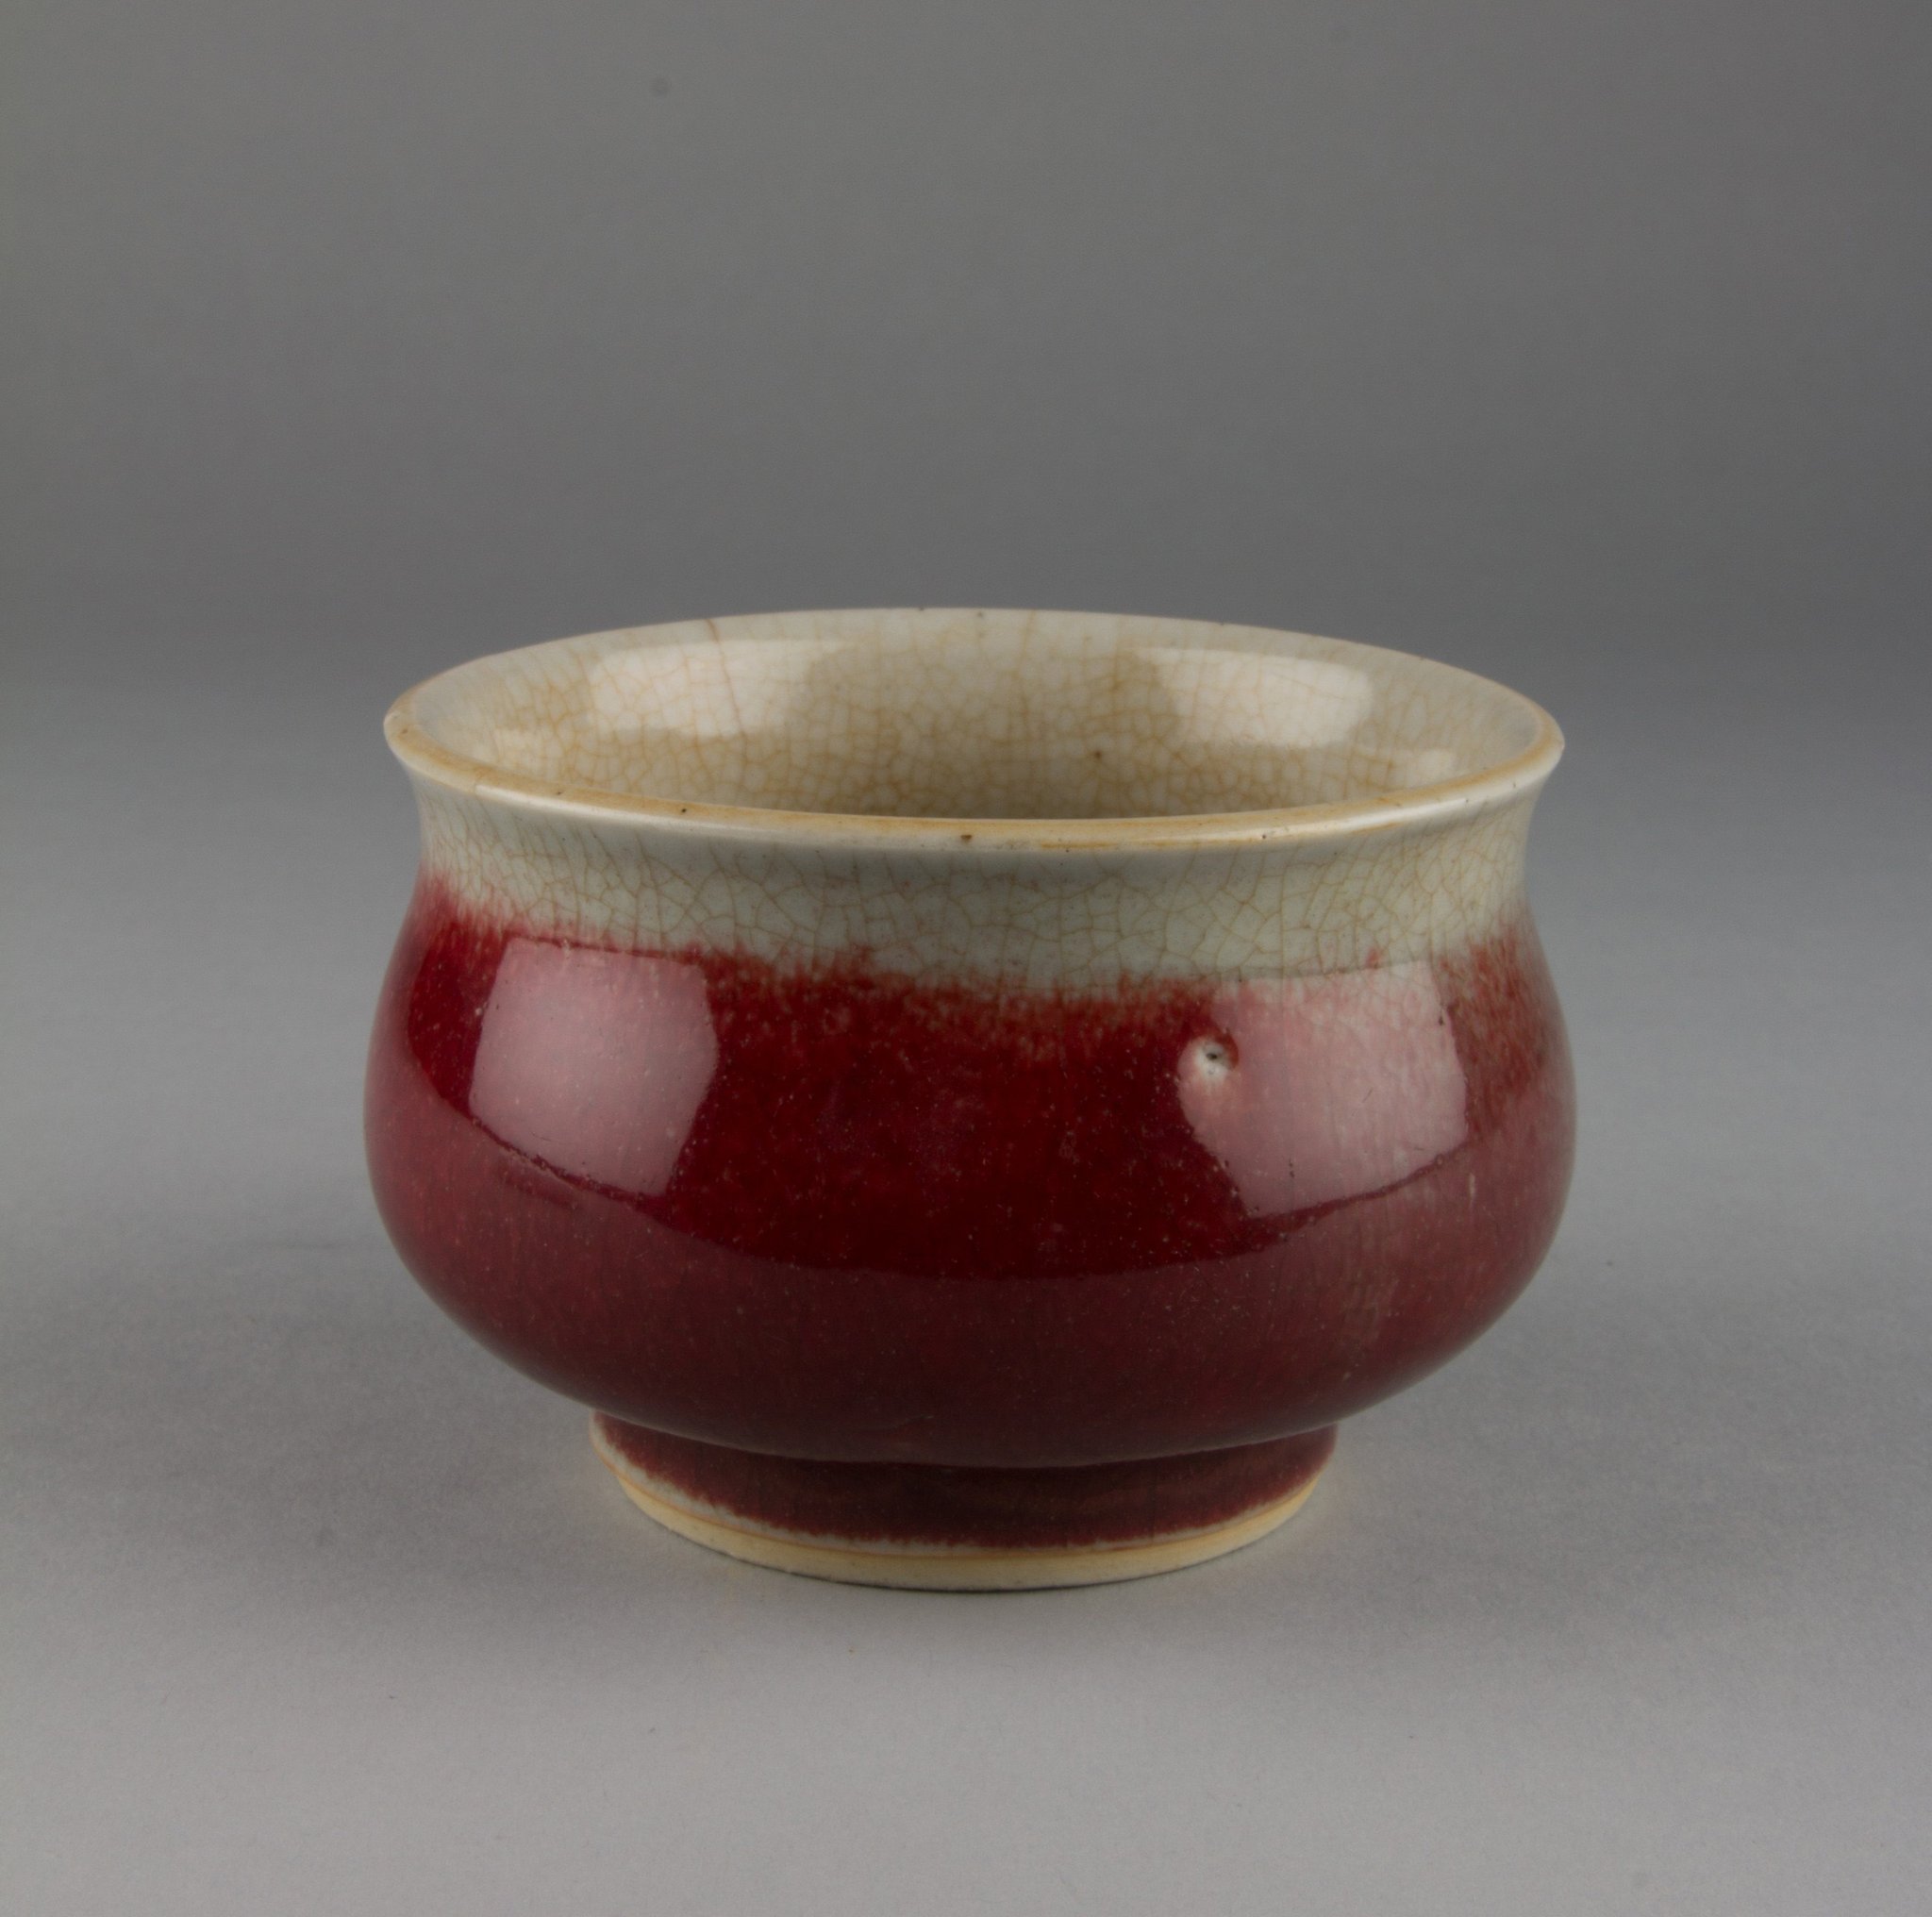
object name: bowl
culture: chinese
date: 1662-1722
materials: glaze, porcelain